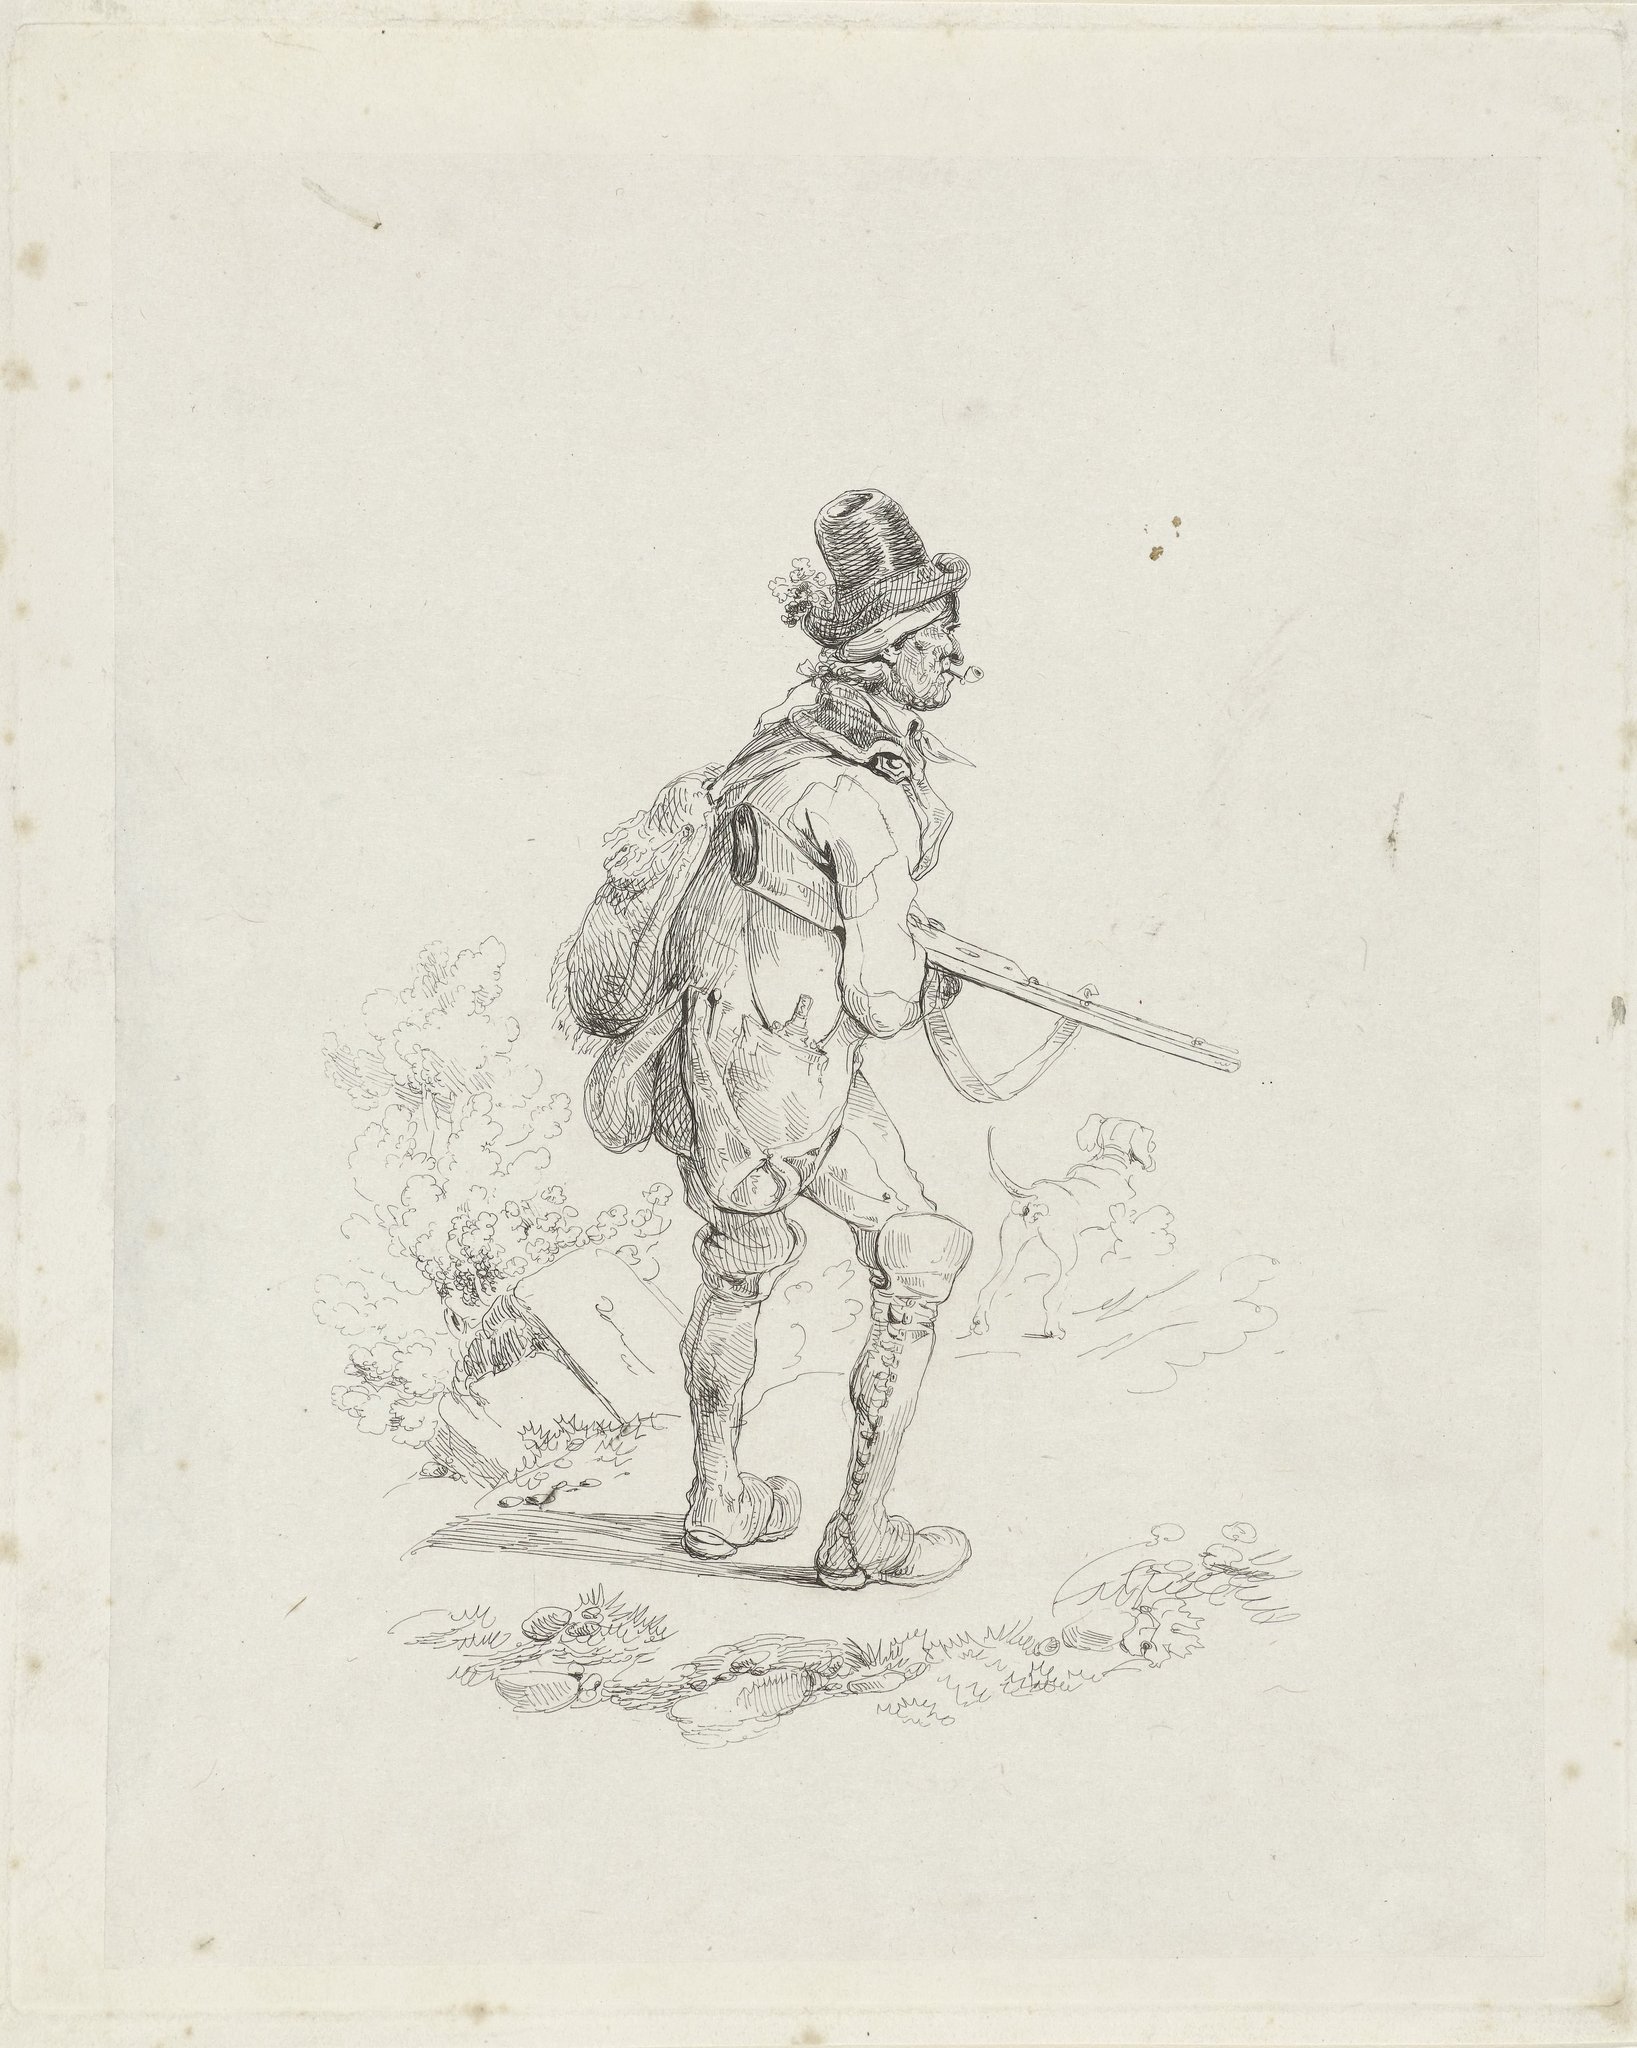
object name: print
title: Jager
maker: gaspard louis françois van kinschot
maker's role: print maker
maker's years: 1811-1861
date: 1821-1861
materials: paper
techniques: etching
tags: hunting dogs, hunter, pipe ~ tobacco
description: In een landschap loopt een jager achter zijn hond aan, naar rechts. Hij rookt een pijp en houdt zijn geweer onder zijn rechterarm.